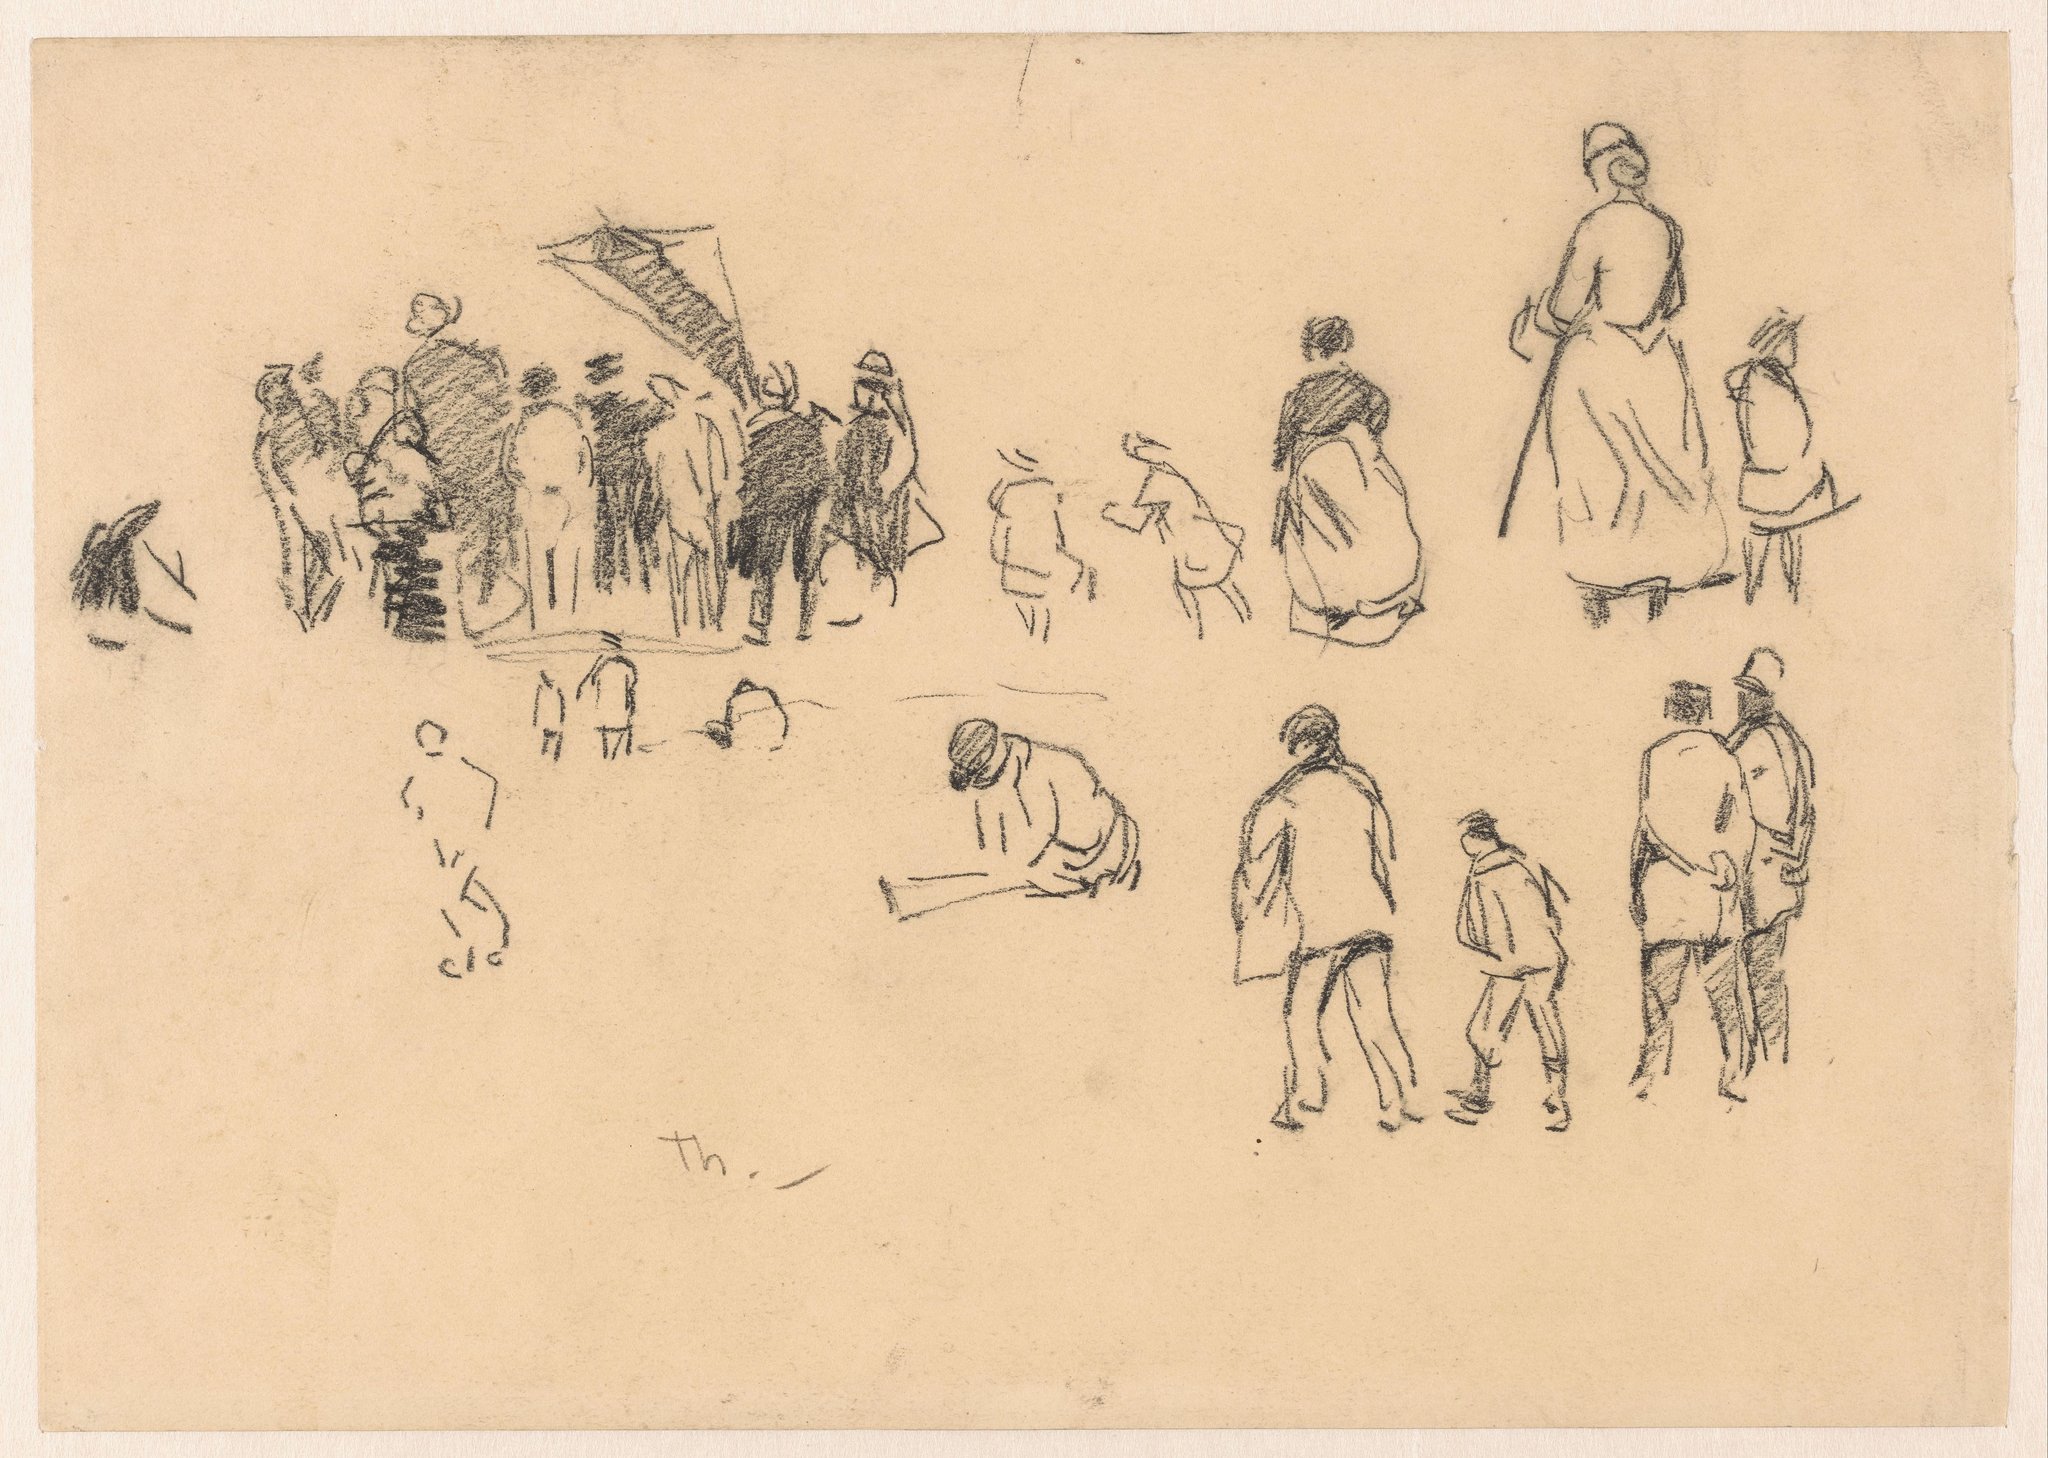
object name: drawing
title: Studieblad met diverse toeschouwers op de rug gezien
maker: willem bastiaan tholen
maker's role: draughtsman, painter, print maker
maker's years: 1860-1931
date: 1870-1931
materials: chalk, paper